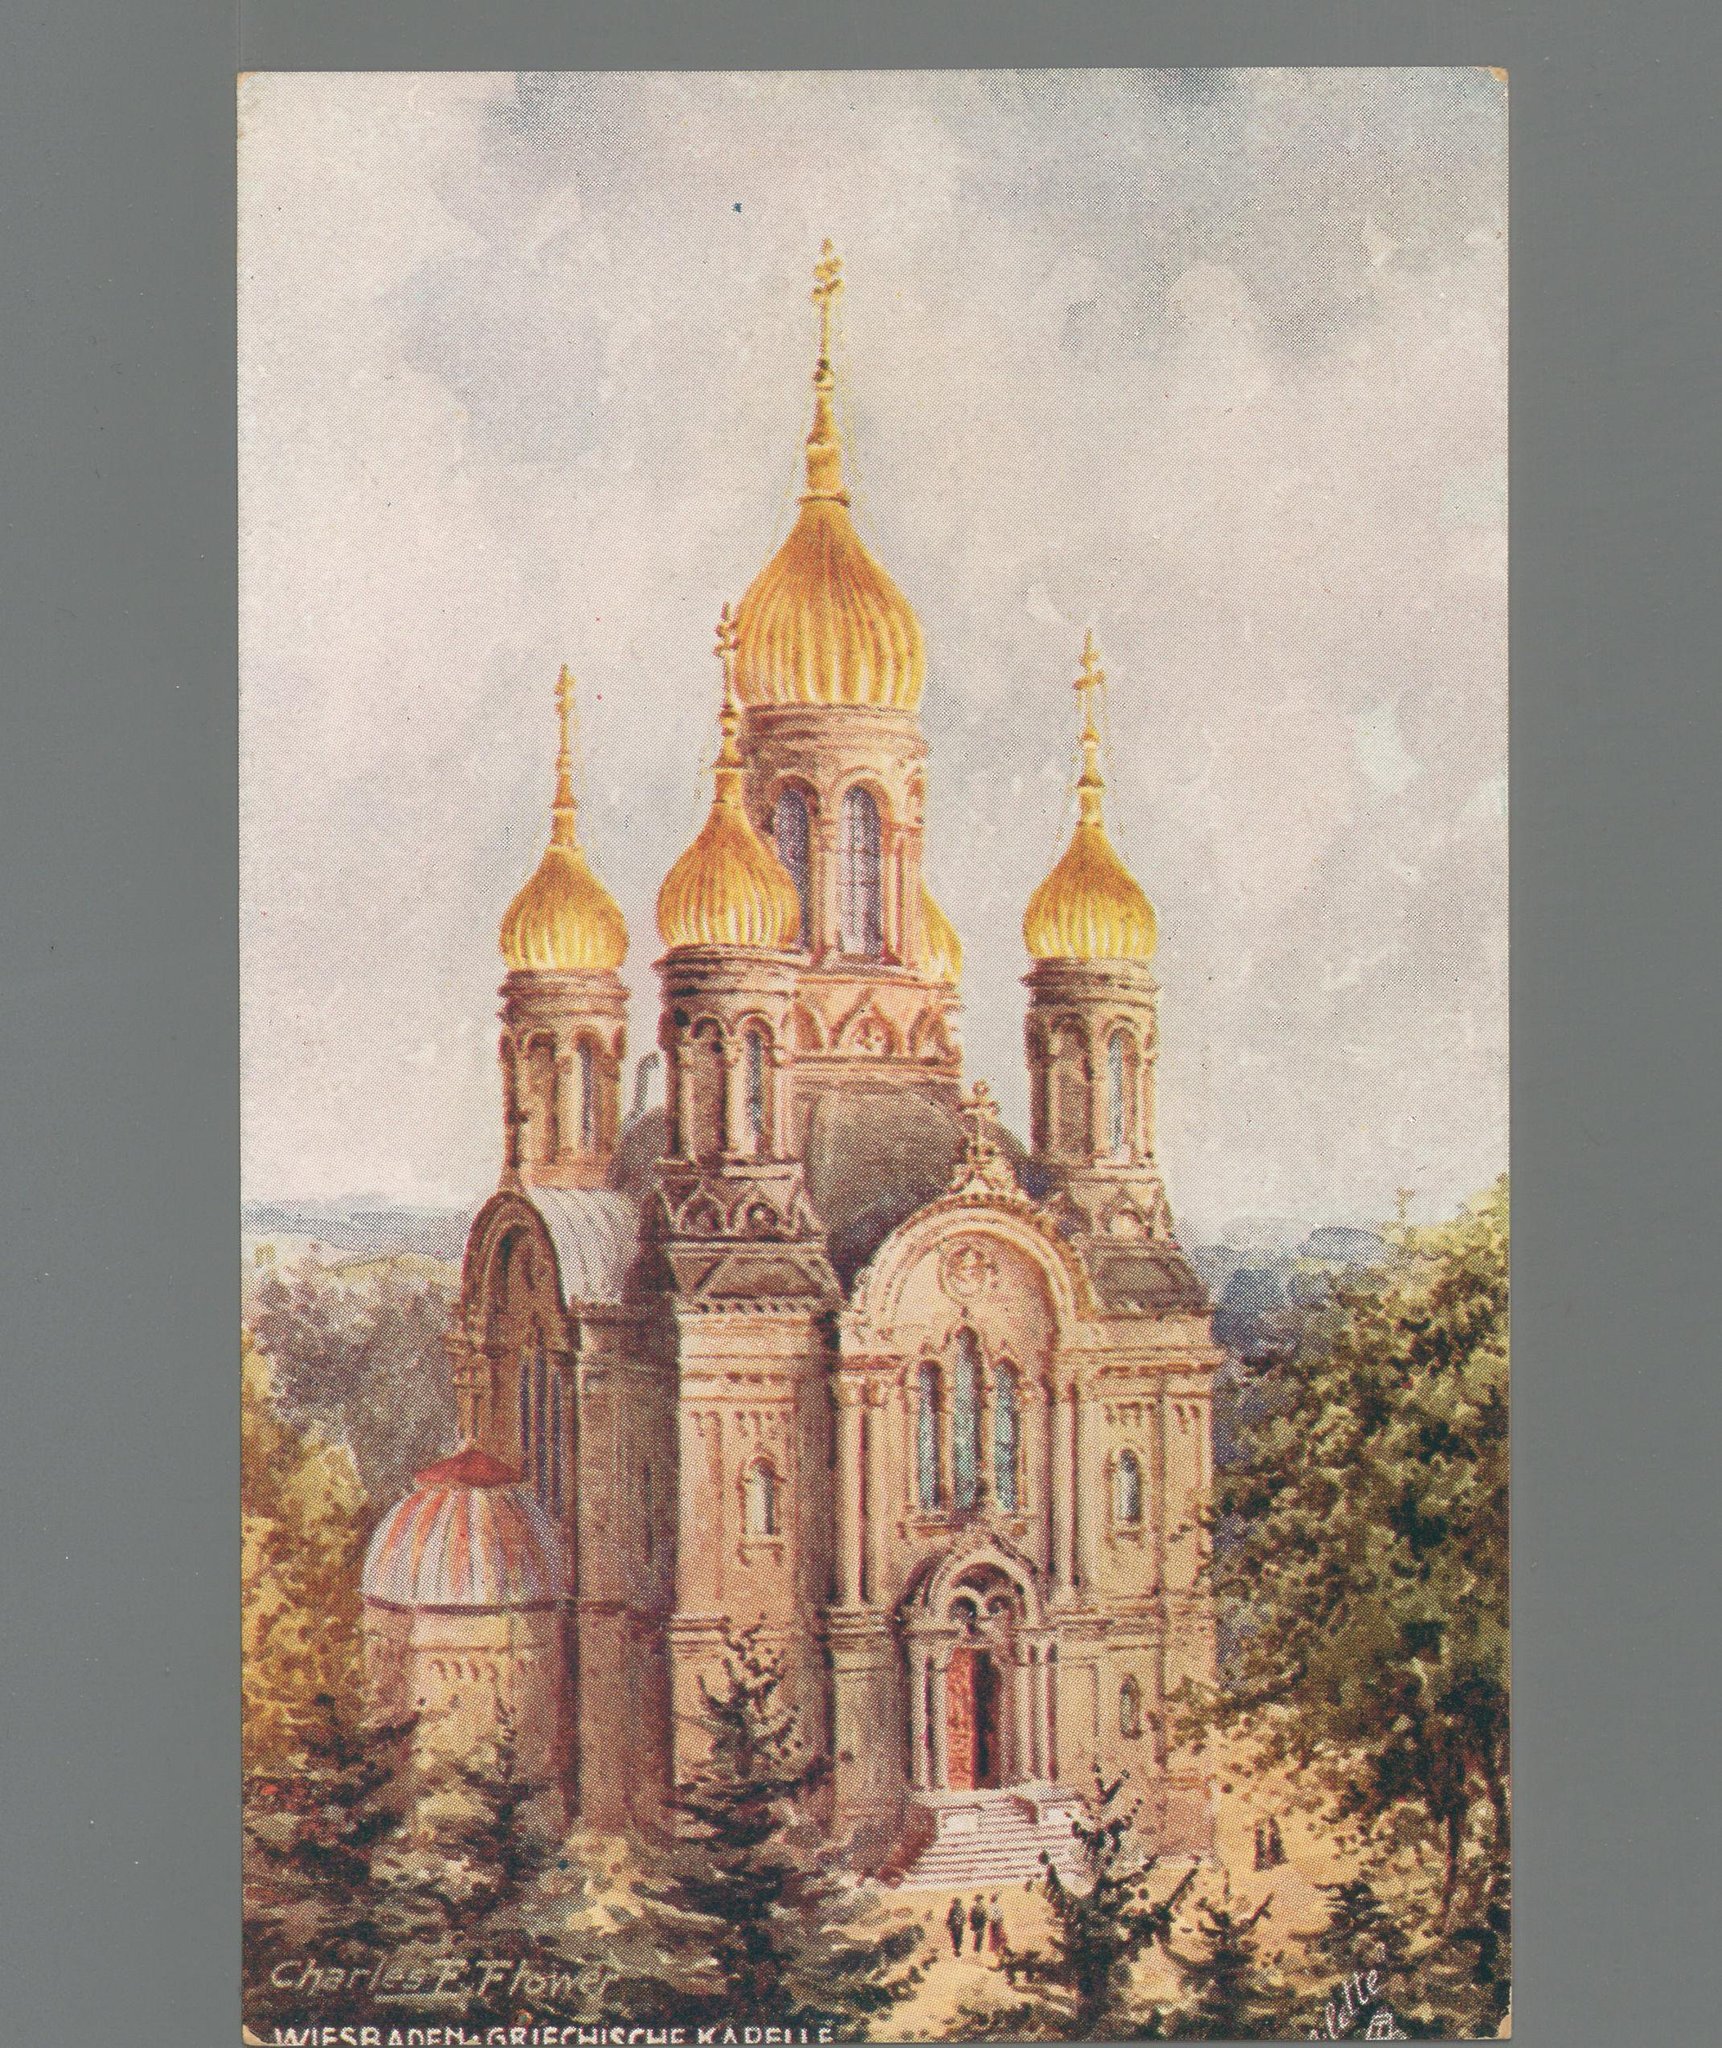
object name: photomechanical print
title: Weite-Weite-Welt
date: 1908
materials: cardboard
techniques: writing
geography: london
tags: church (exterior)